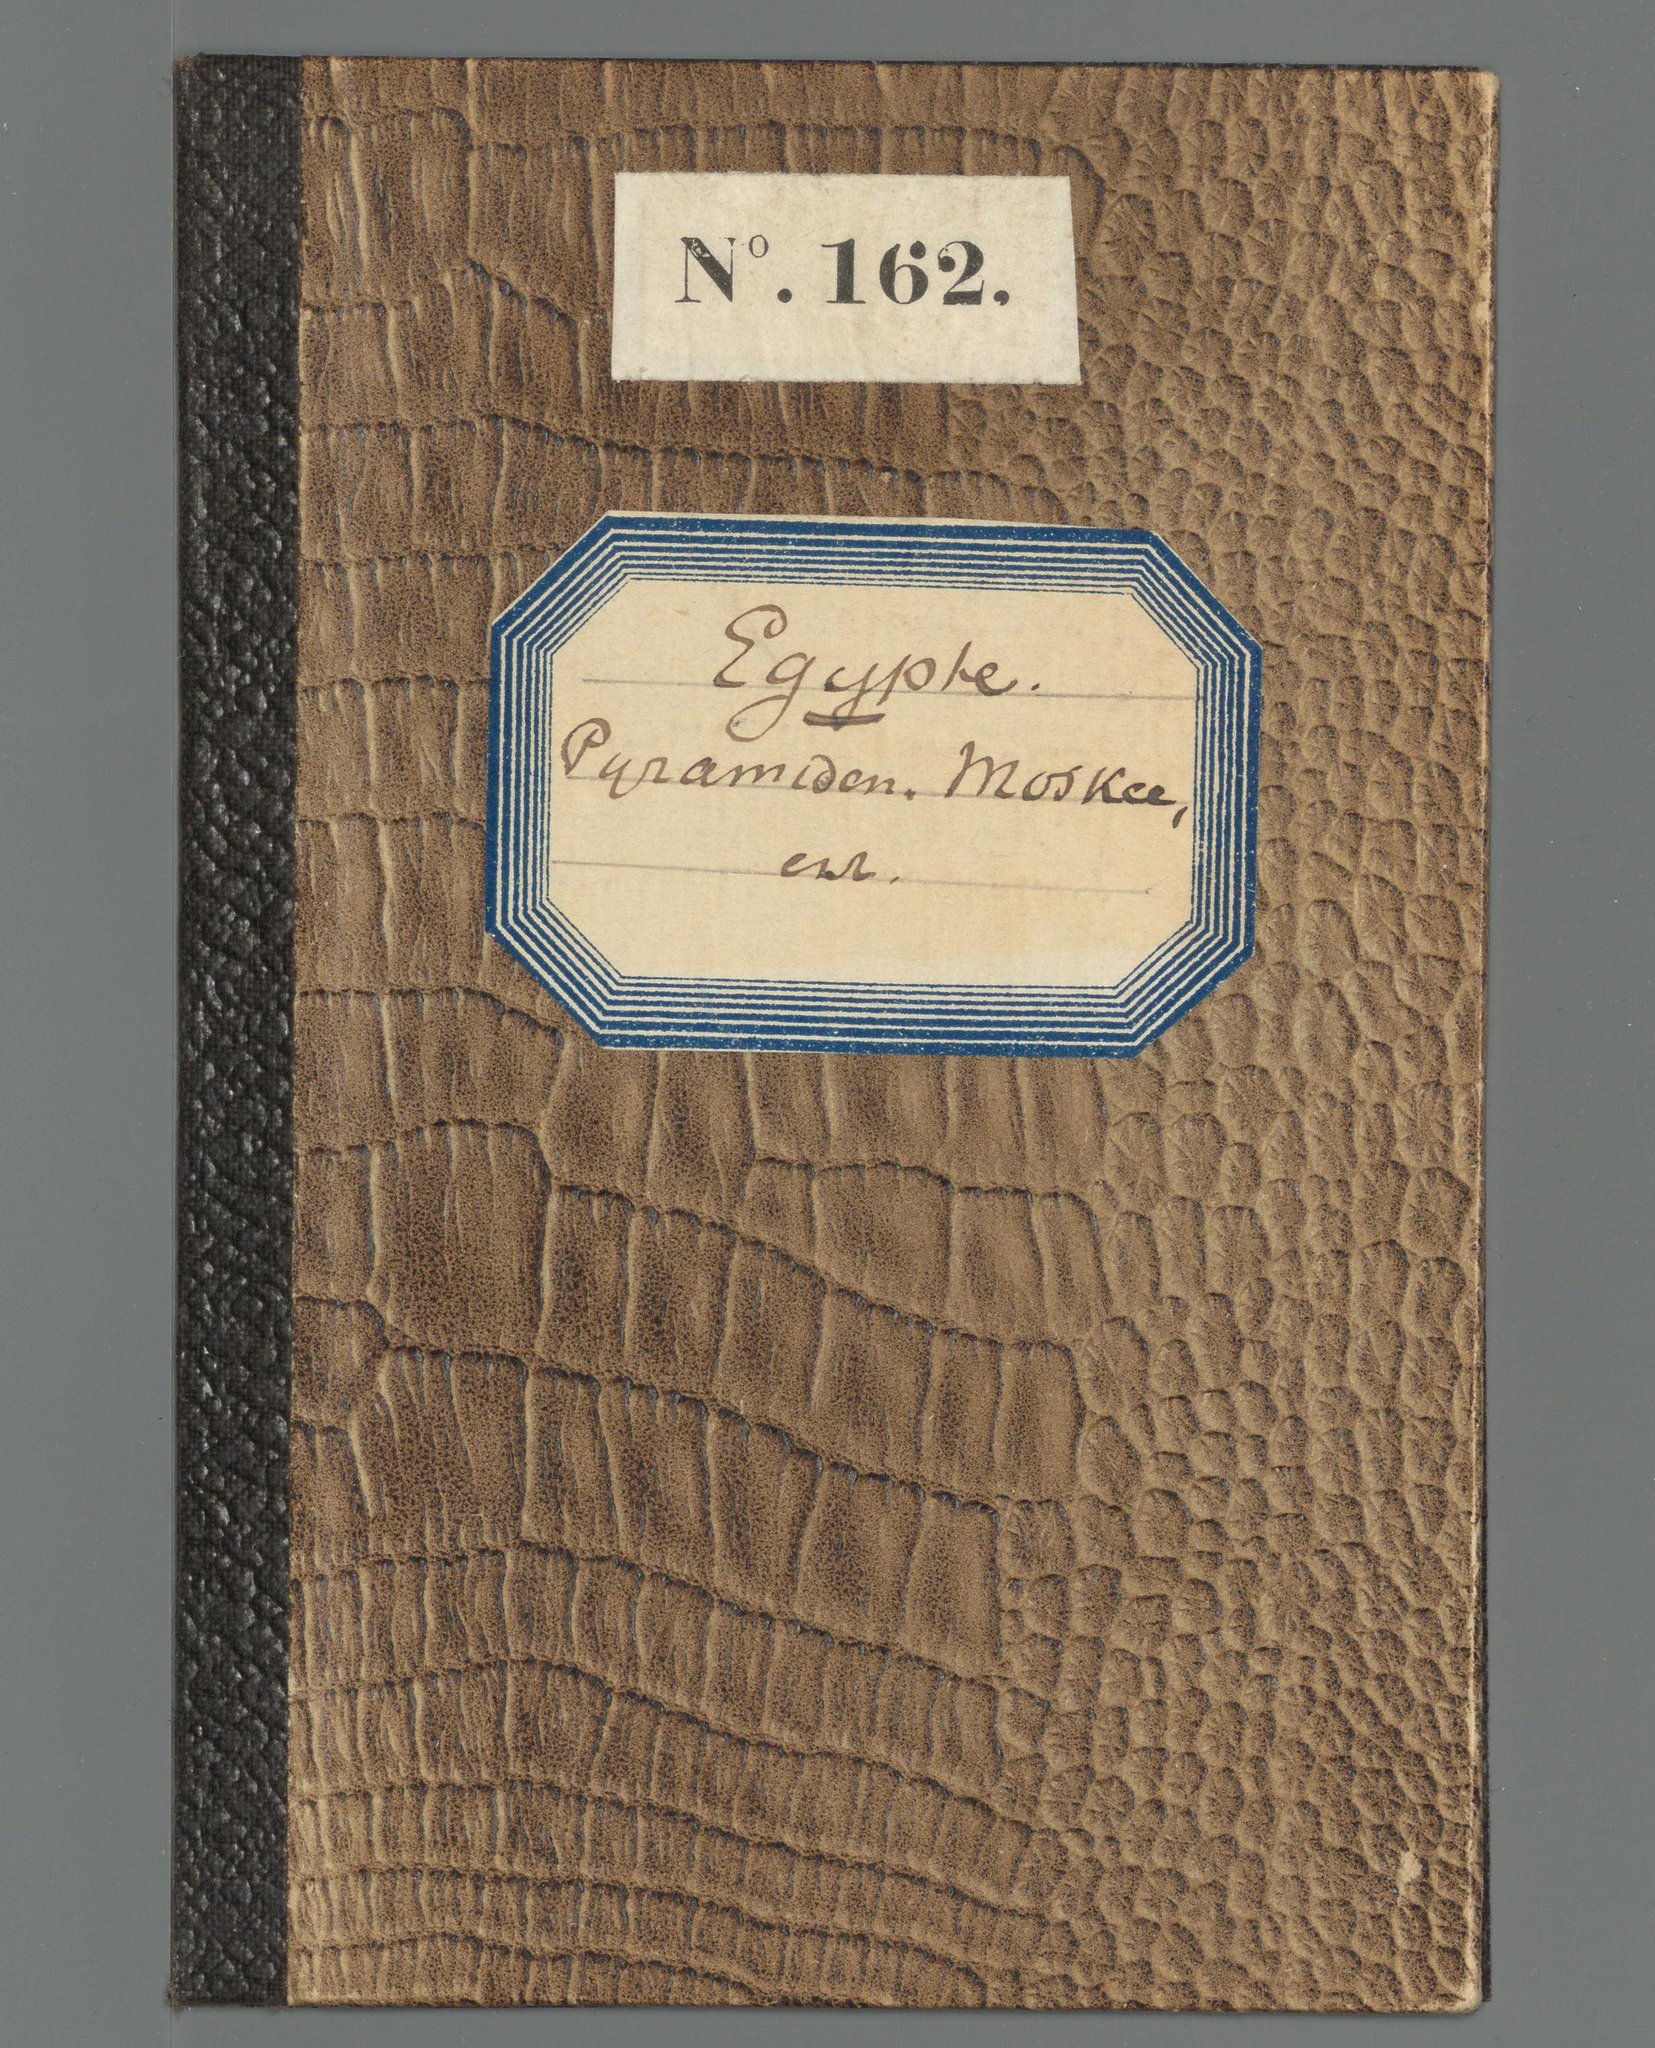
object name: wrapper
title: Omslag voor 26 prentbriefkaarten met gezichten uit Egypte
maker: Anonymous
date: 1900-1950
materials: cardboard, paper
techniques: lithograph, writing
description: In de omslag zit een kaart ingestoken met daarop een korte beschrijving van de inhoud.